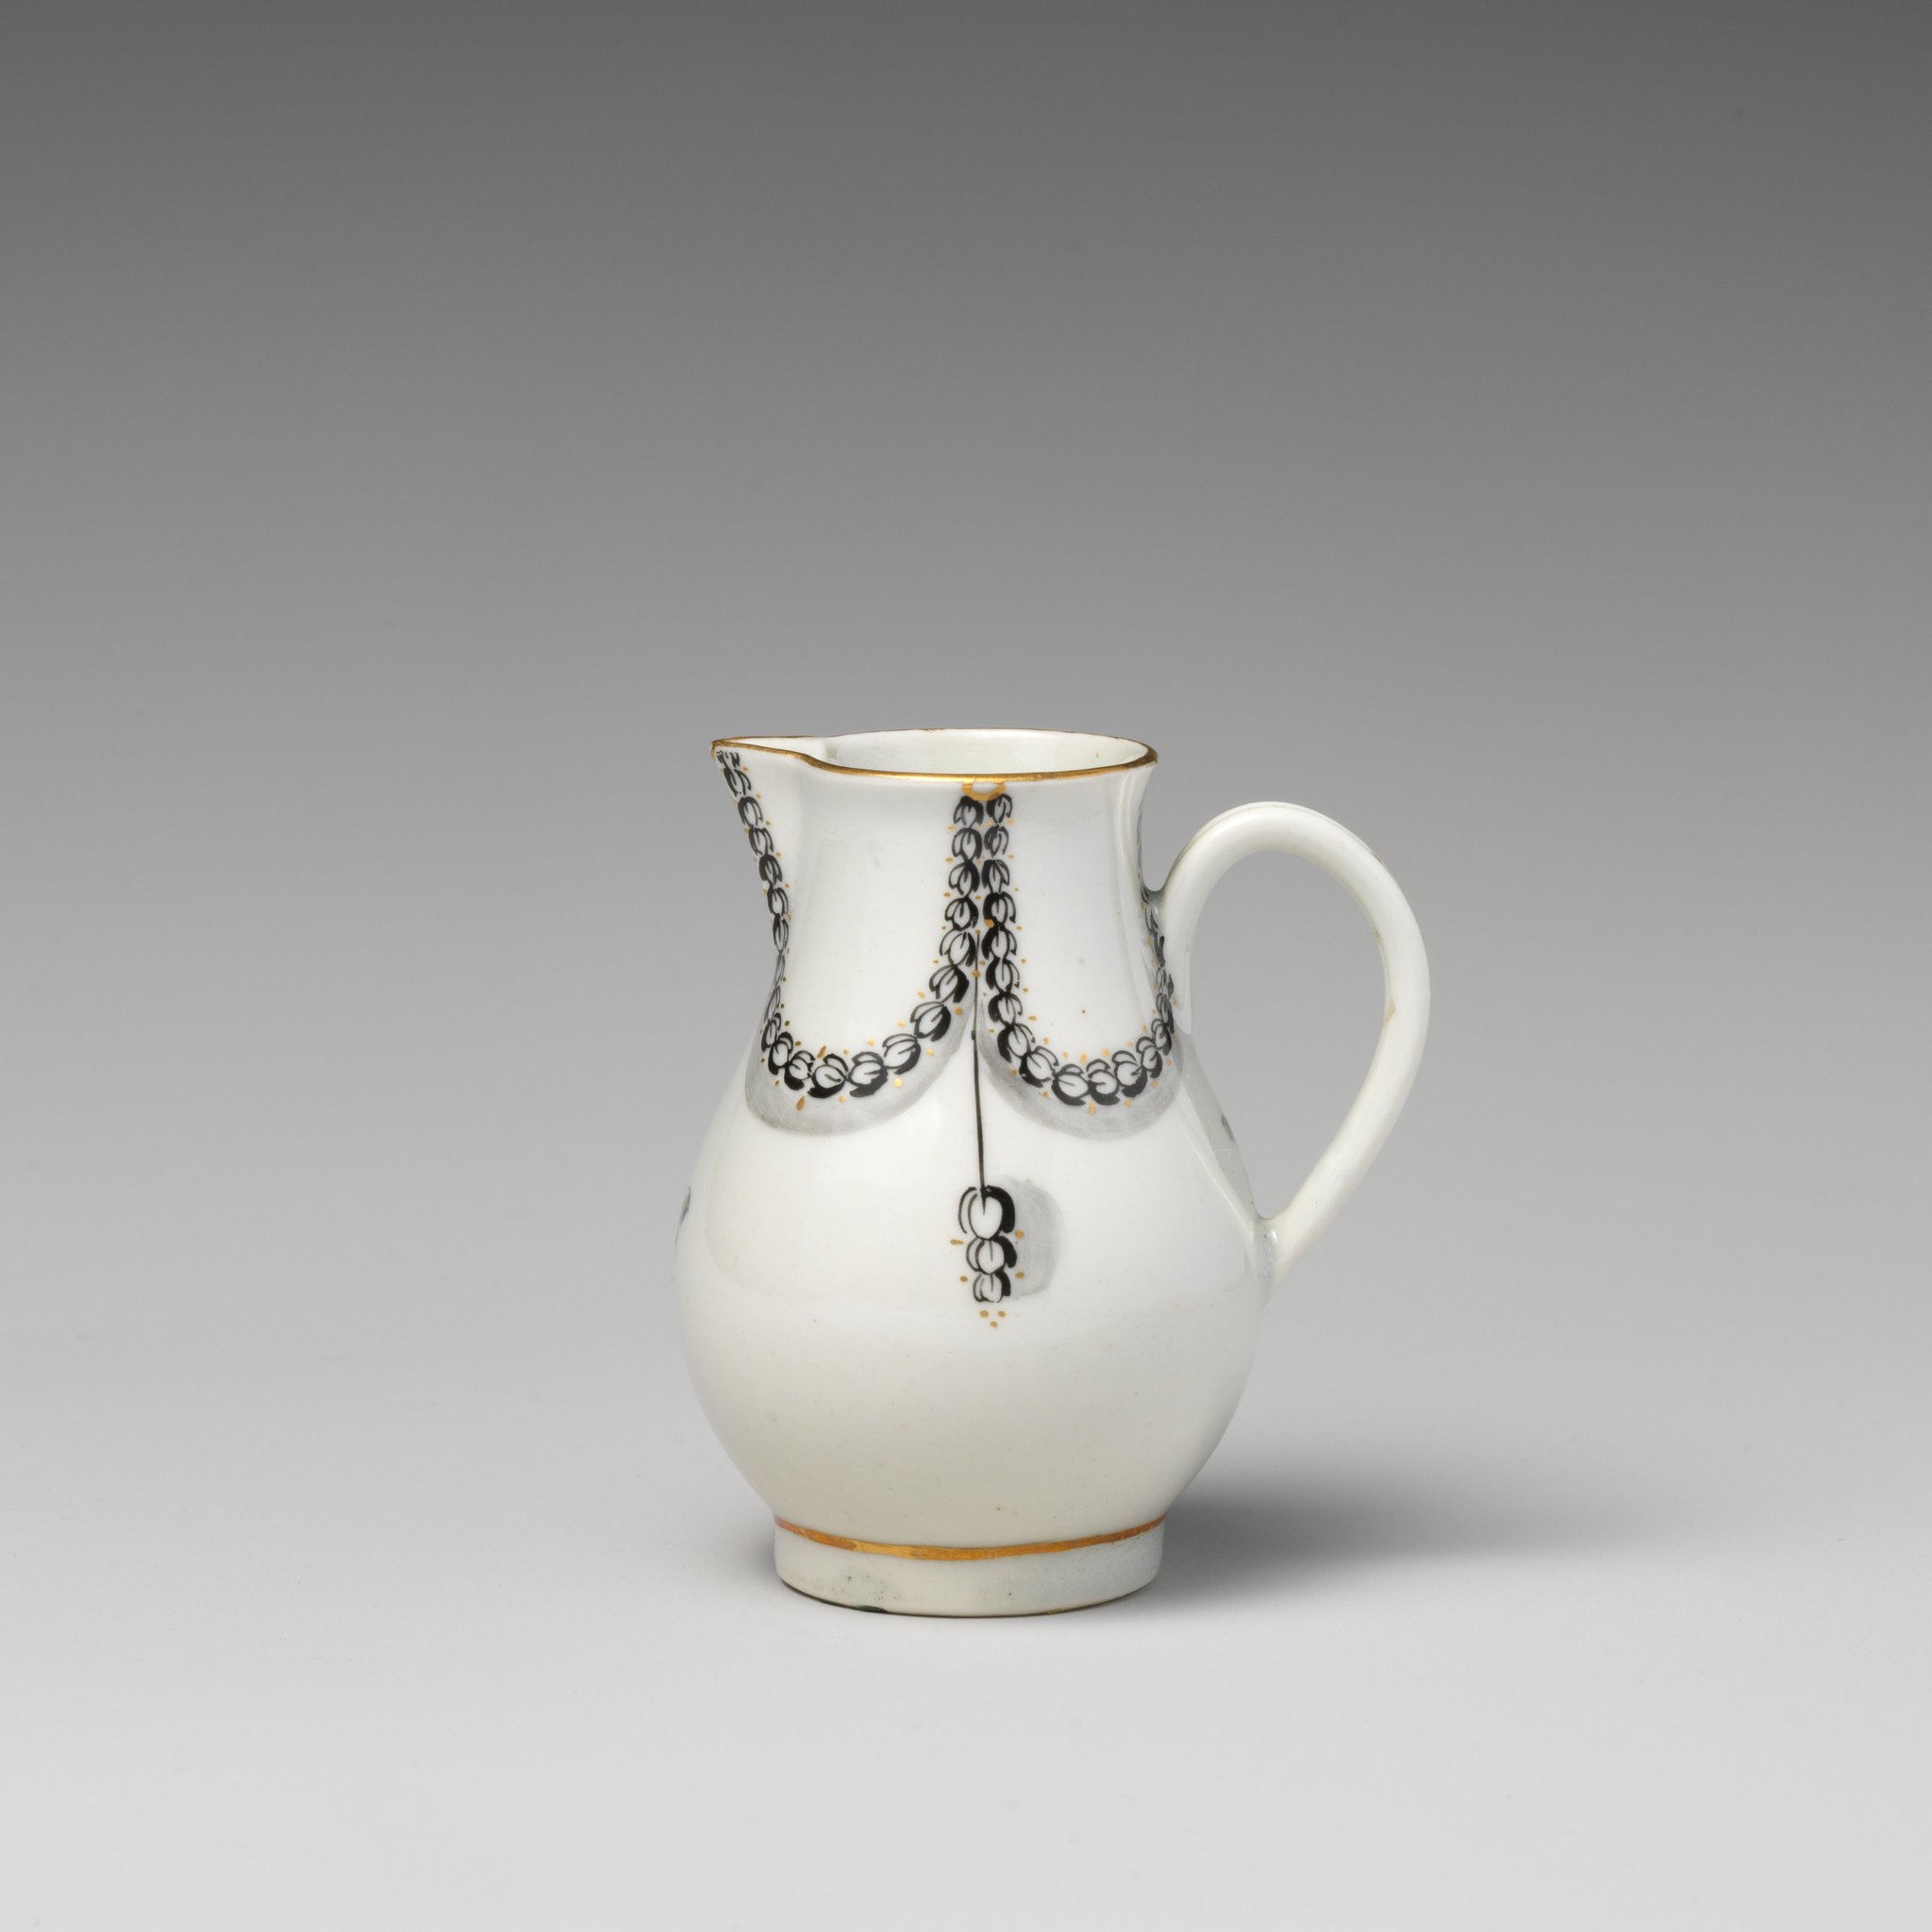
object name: cream pitcher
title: Cream pitcher (part of a service)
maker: caughley factory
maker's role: factory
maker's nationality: british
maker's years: 1772-1799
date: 1780-1790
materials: enamel, soft paste porcelain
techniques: gilding